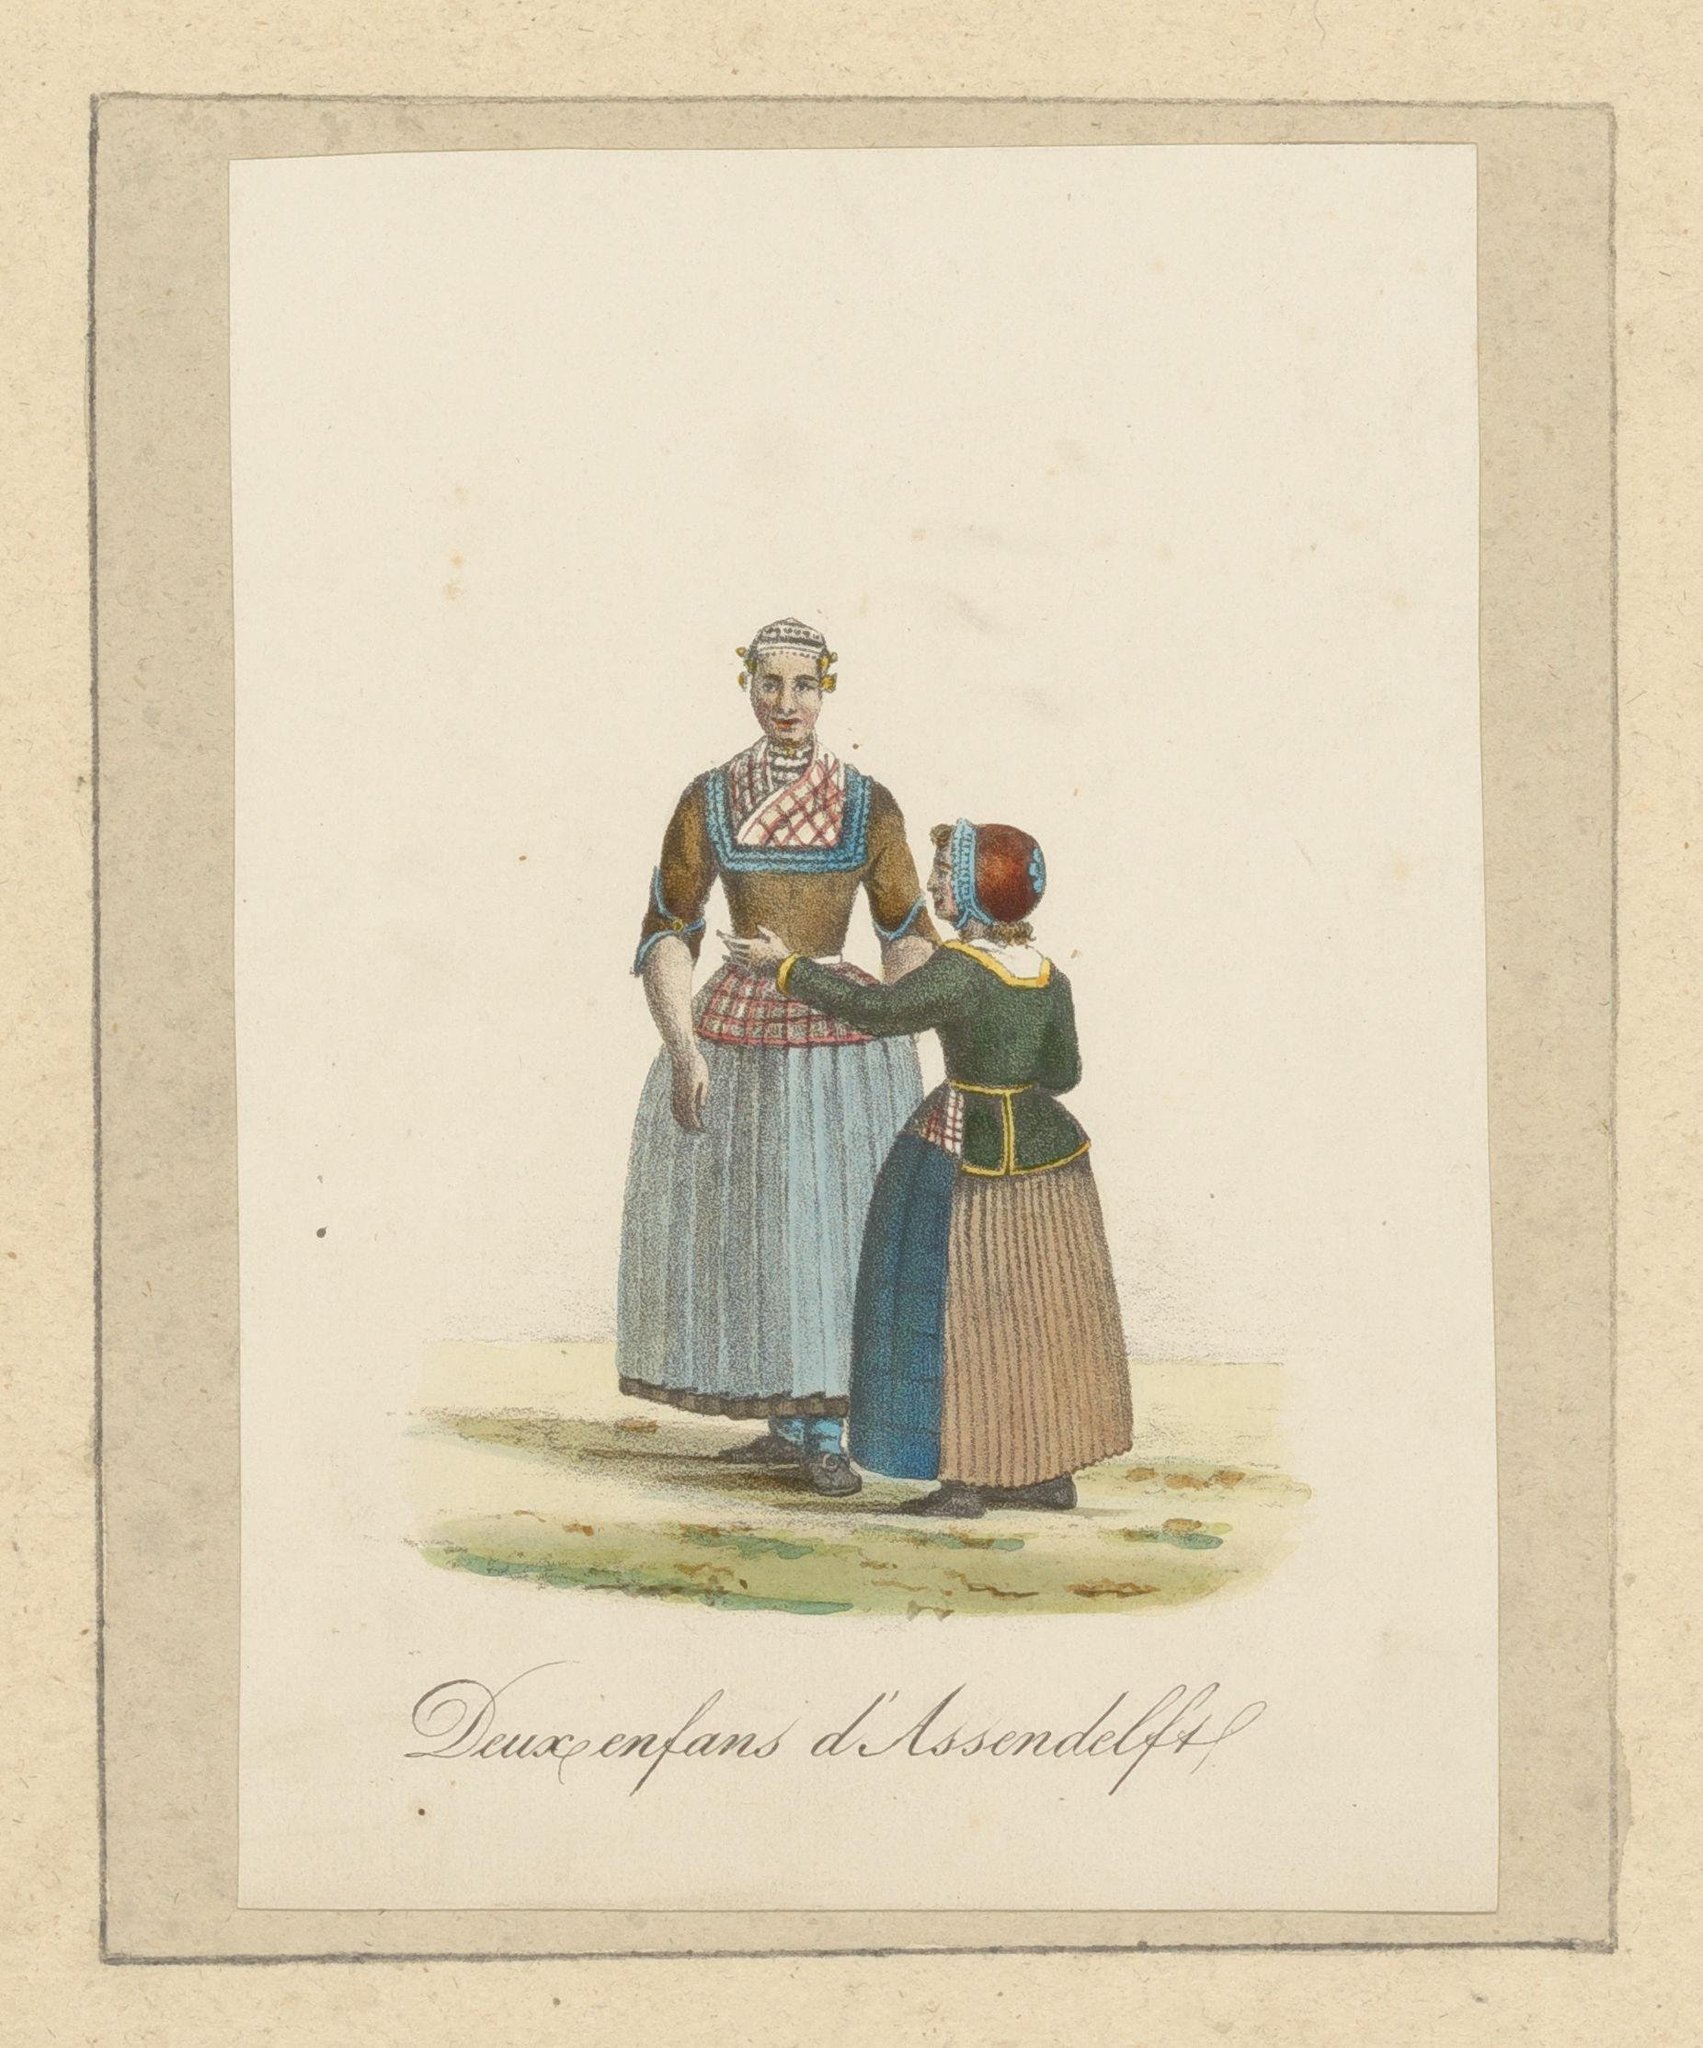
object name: print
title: Kinderen van Assendelft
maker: Anonymous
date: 1830-1899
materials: paper, watercolor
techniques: hand coloring, lithograph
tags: clothes, costume (+ children's clothes), folk costume, regional costume, assendelft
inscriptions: collector's mark, collector's mark: Lugt 1641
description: Twee kinderen in klederdracht van Assendelft. Onderwerpsrubrieken binnen de Atlas Zeden en Gewoonten: De Kleeding, Volkskleederdracht, Noord-Holland.